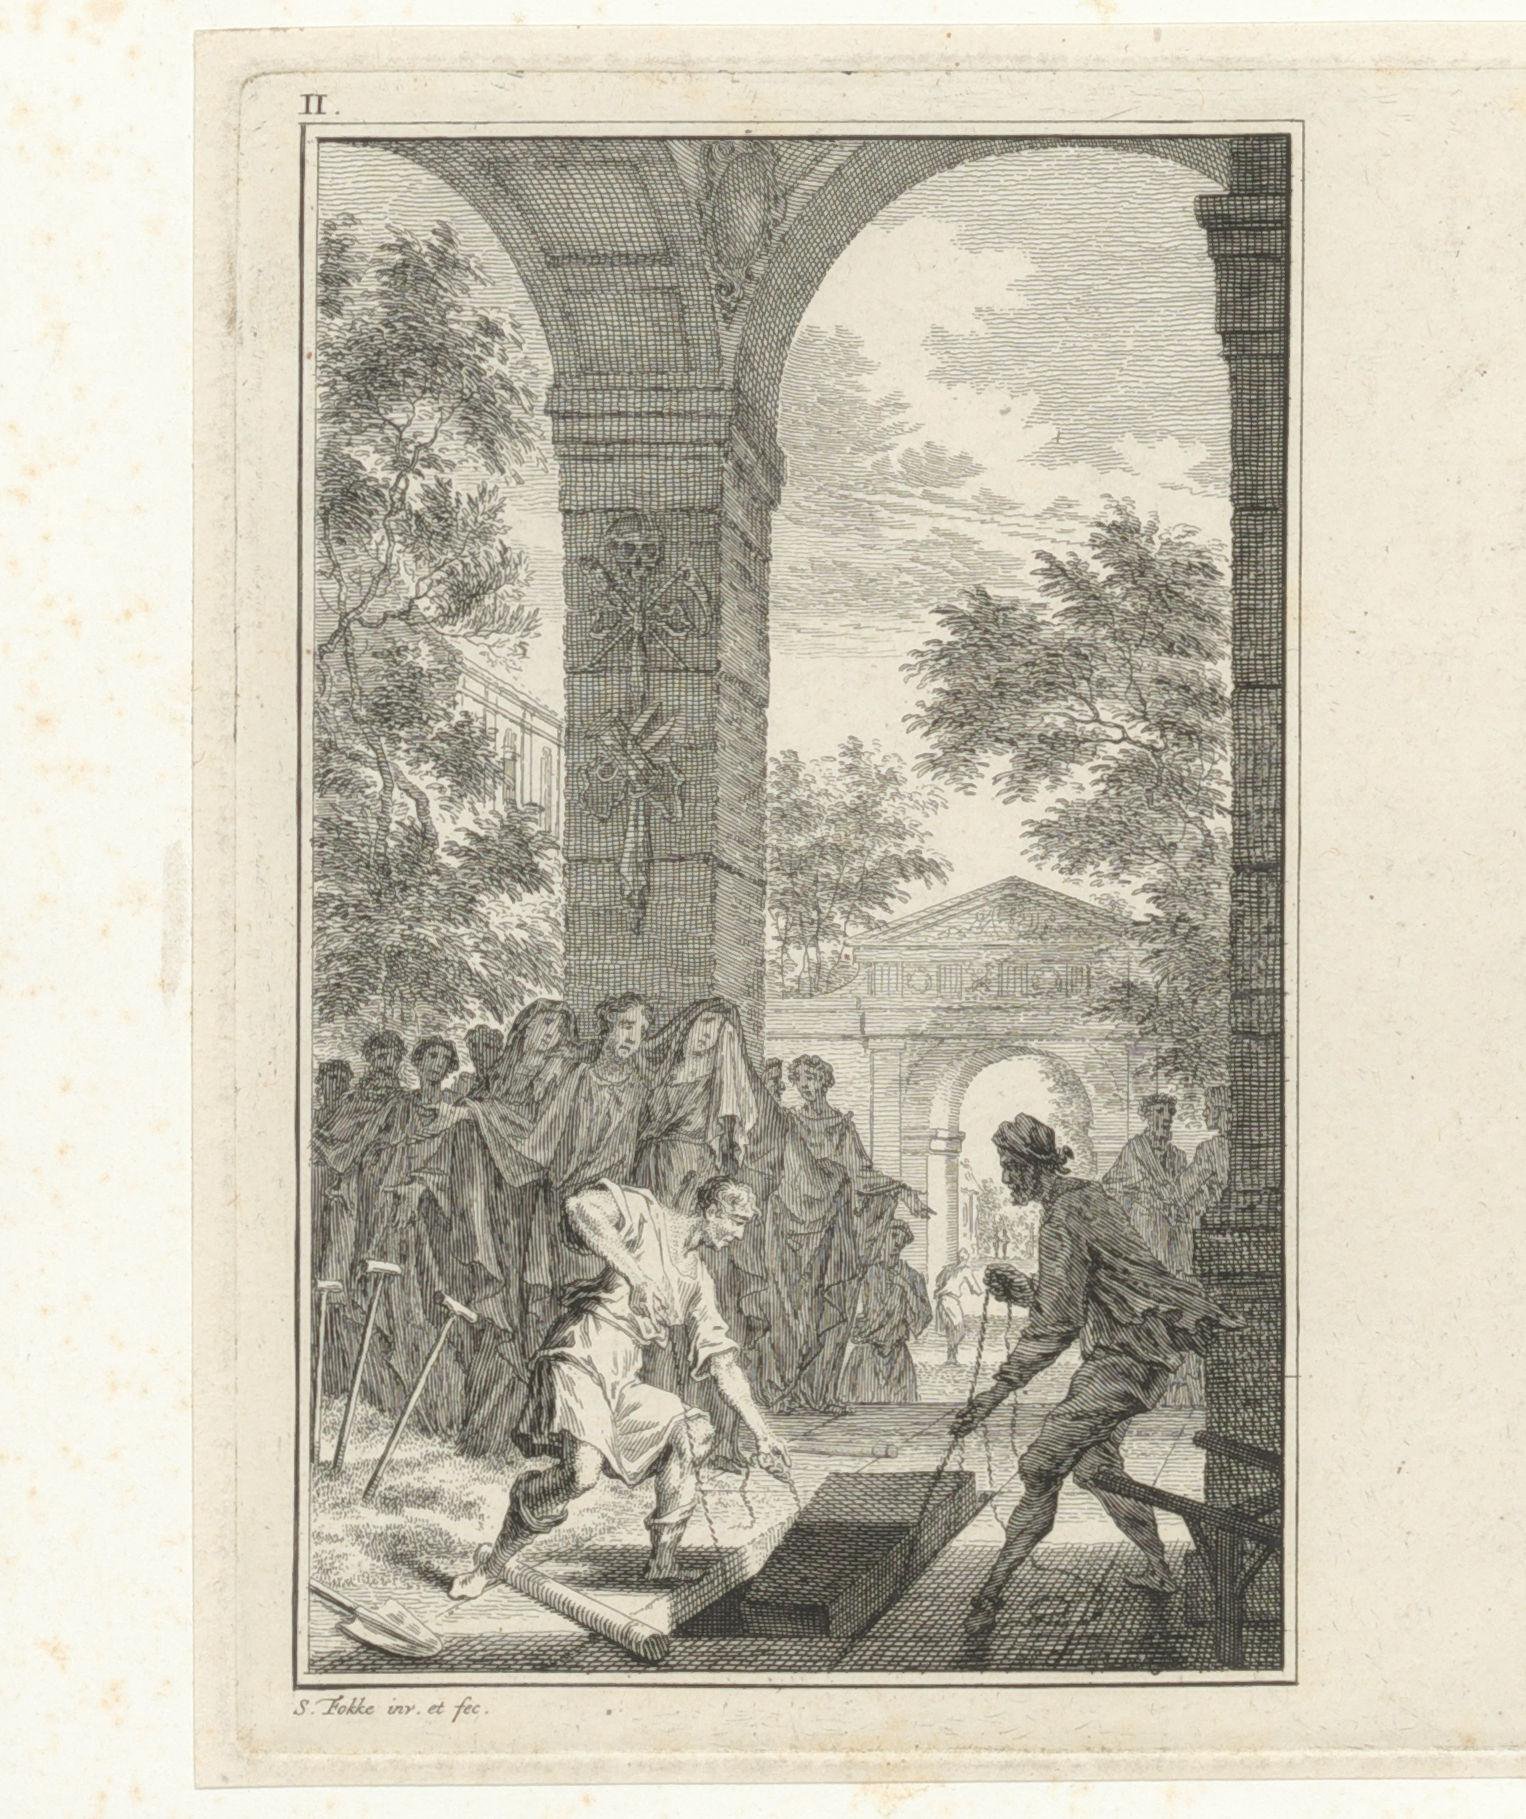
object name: print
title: Begrafenis en sterfbed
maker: simon fokke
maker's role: draughtsman, print maker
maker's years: 1712-1784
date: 1722-1784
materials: paper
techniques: etching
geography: amsterdam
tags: burial, deathbed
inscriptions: collector's mark, collector's mark: Lugt 1641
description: Blad met twee voorstellingen op één plaat. Links een begrafenis. Gesluierde vrouwen en mannen kijken met geheven armen toe hoe twee grafgravers een doodskist in de grond laten zakken. Linksboven gemerkt: II. Rechts het sterfbed van een man, omringd door familie en vrienden. Gemerkt rechtsboven: IV. Onderwerpsrubrieken binnen de Atlas Zeden en Gewoonten: Des Menschen Begin, Midden en Einde. Begrafenissen, varia.